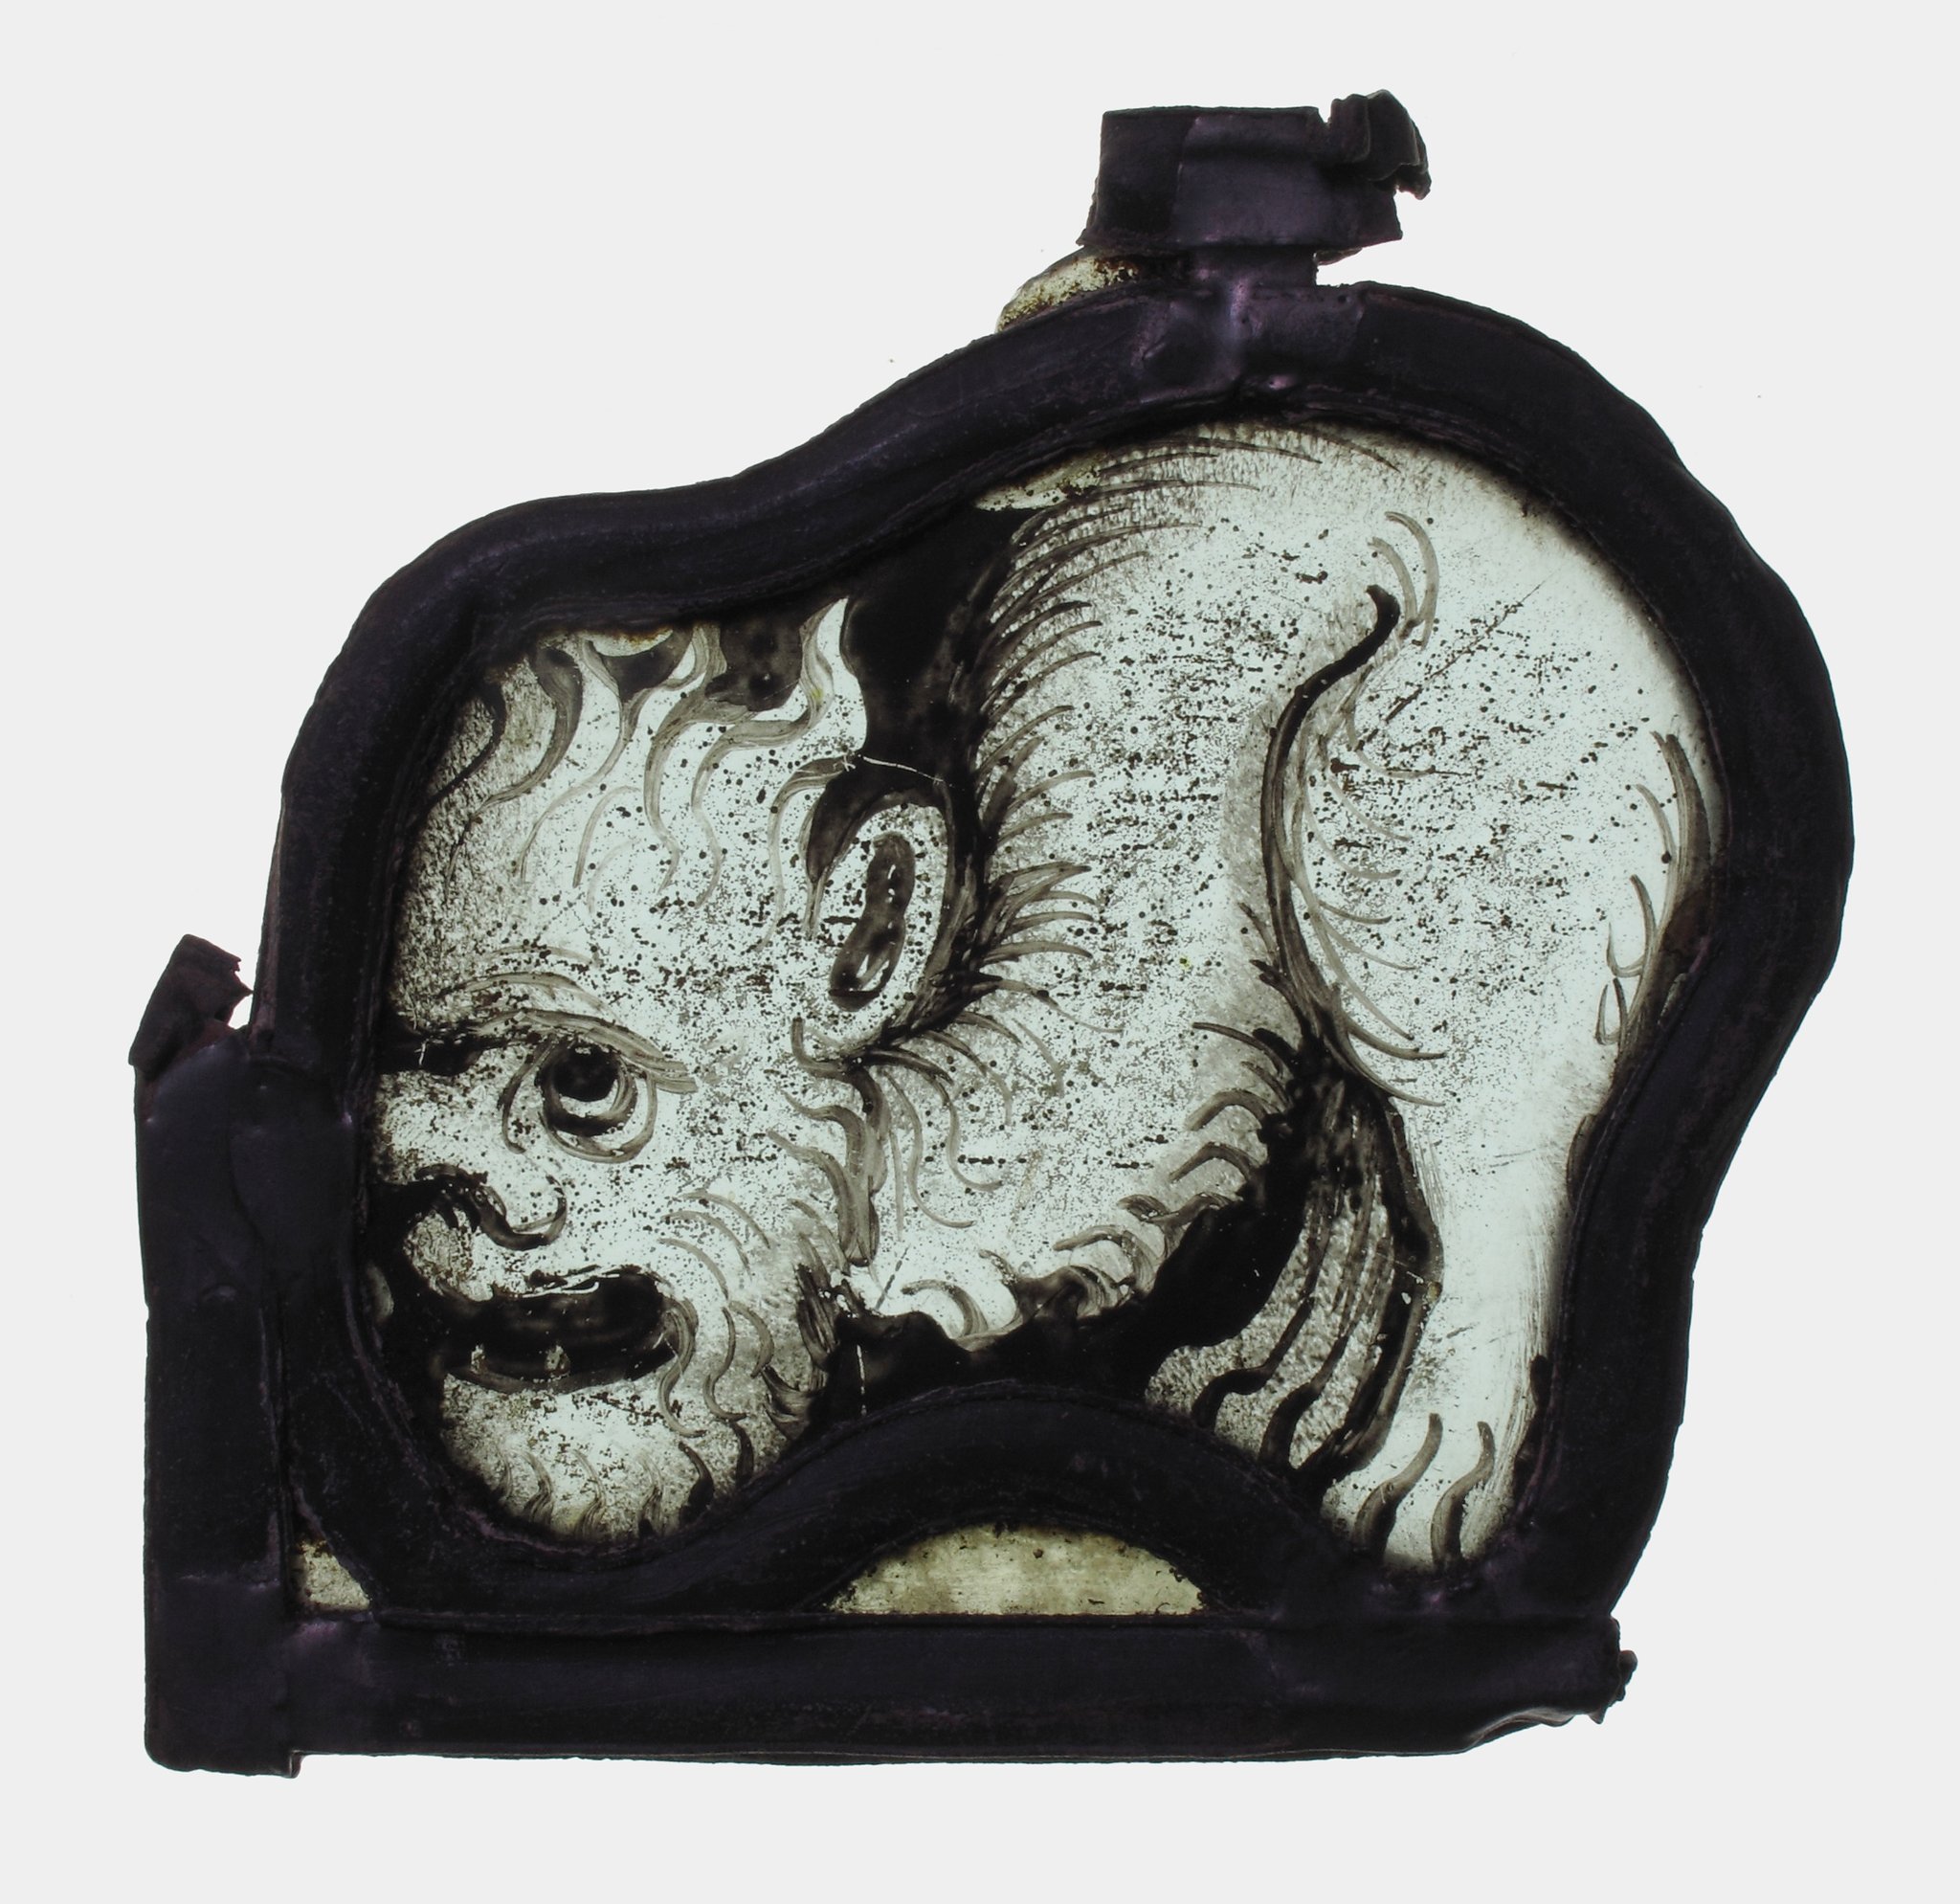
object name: fragment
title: Glass Fragment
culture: european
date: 1301-1500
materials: glass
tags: mythical creatures